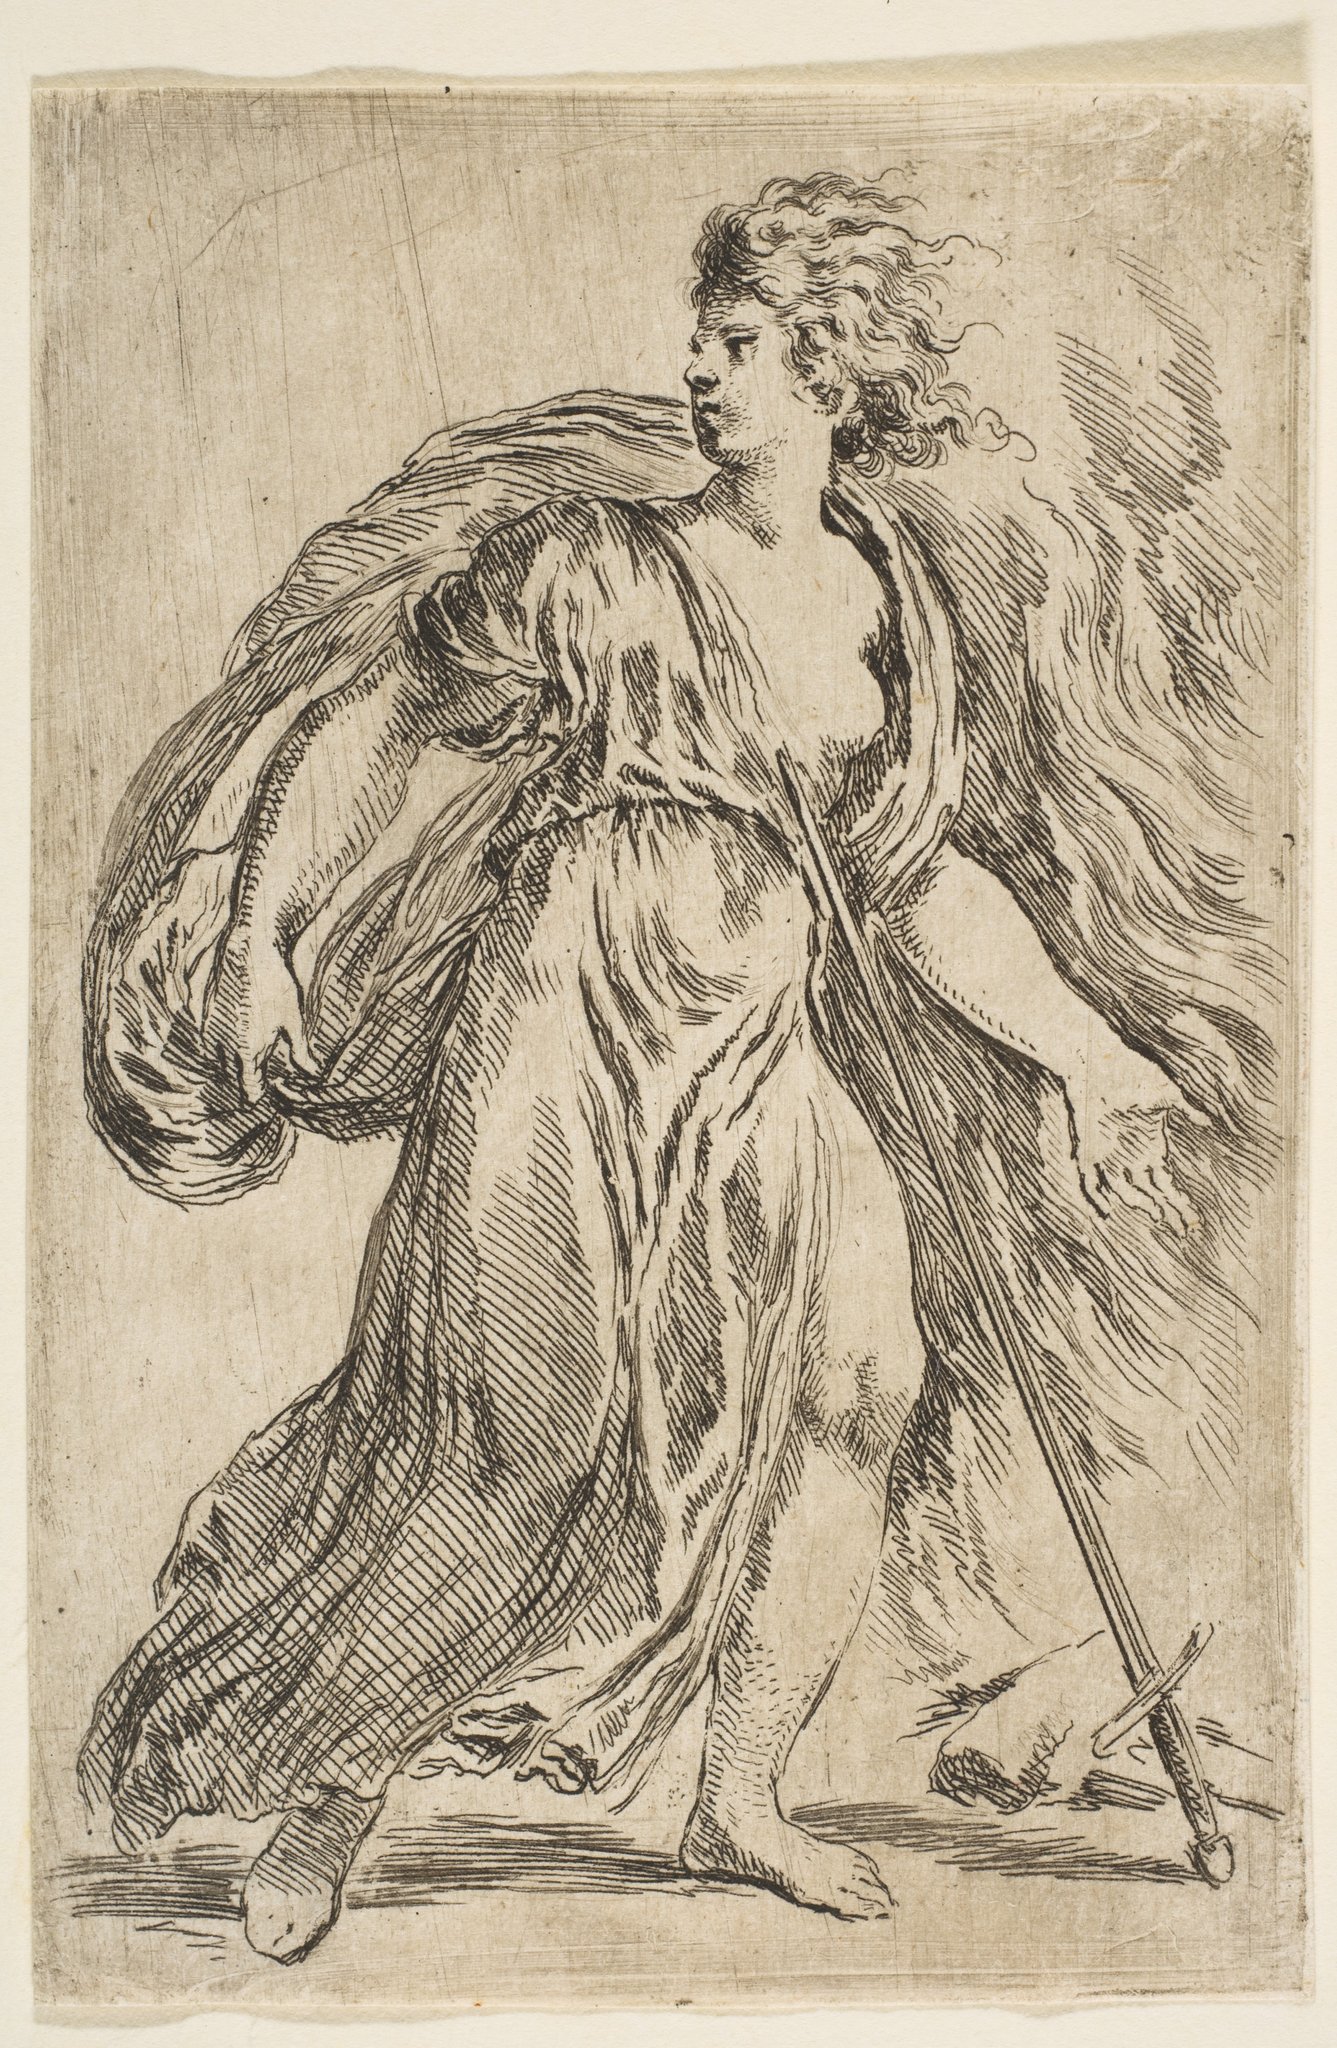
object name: print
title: Dido Killing Herself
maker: stefano della bella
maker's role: artist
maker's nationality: italian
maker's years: 1610-1664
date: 1660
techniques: etching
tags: swords,women